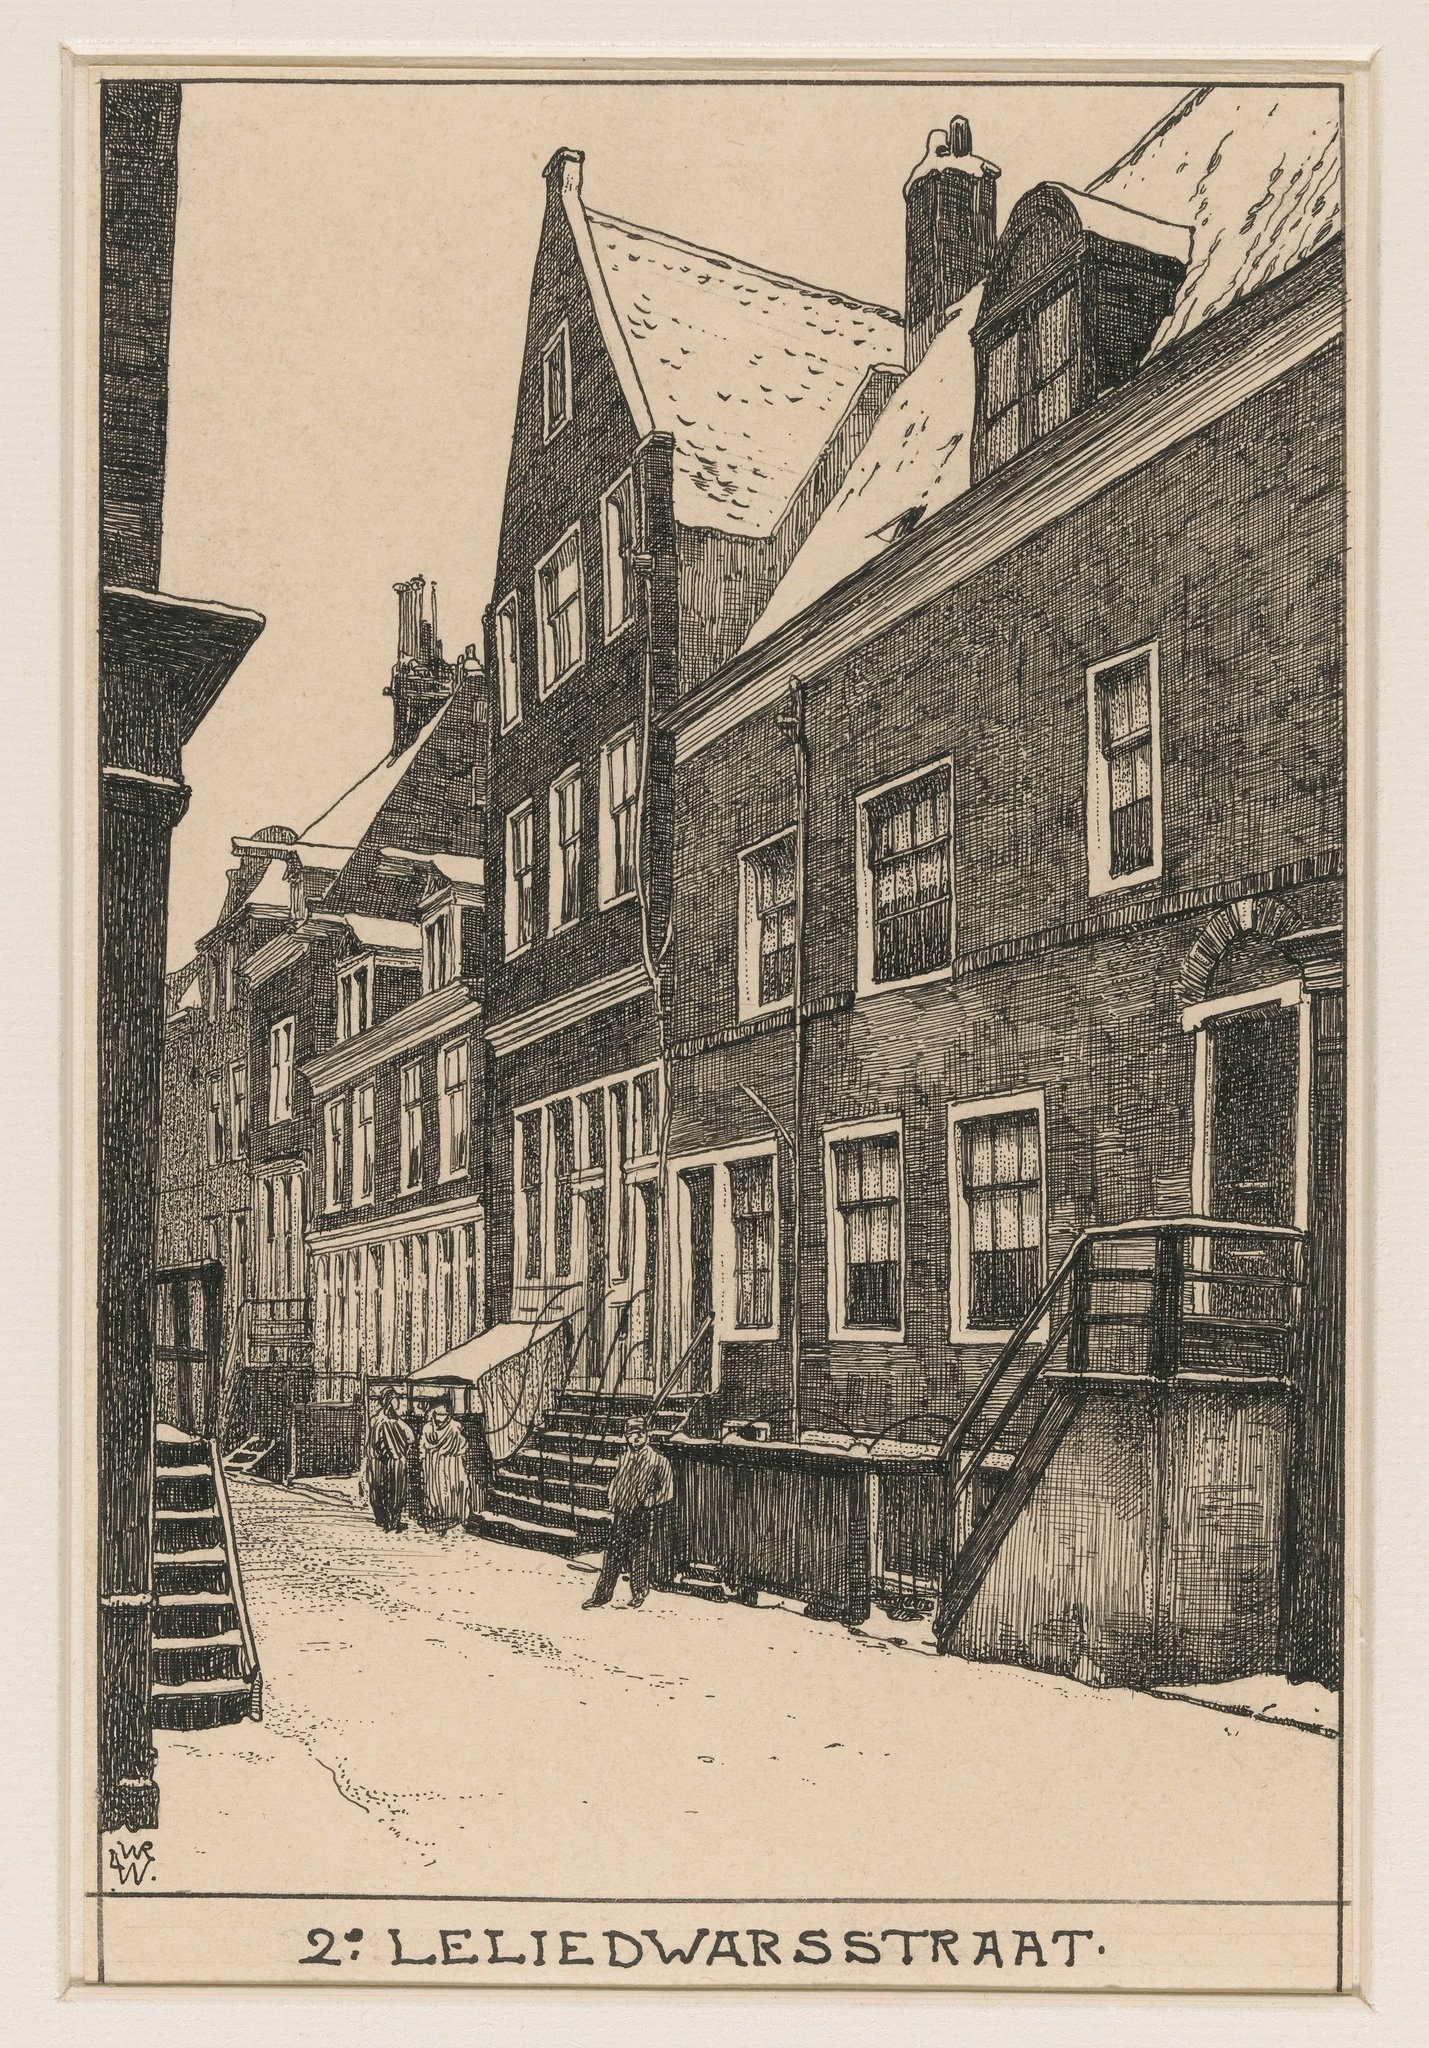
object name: drawing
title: De 2de Leliedwarsstraat te Amsterdam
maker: willem wenckebach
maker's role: designer, draughtsman, painter, print maker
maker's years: 1860-1937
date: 1870-1926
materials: ink, paper, pencil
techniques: pen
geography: amsterdam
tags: street, amsterdam